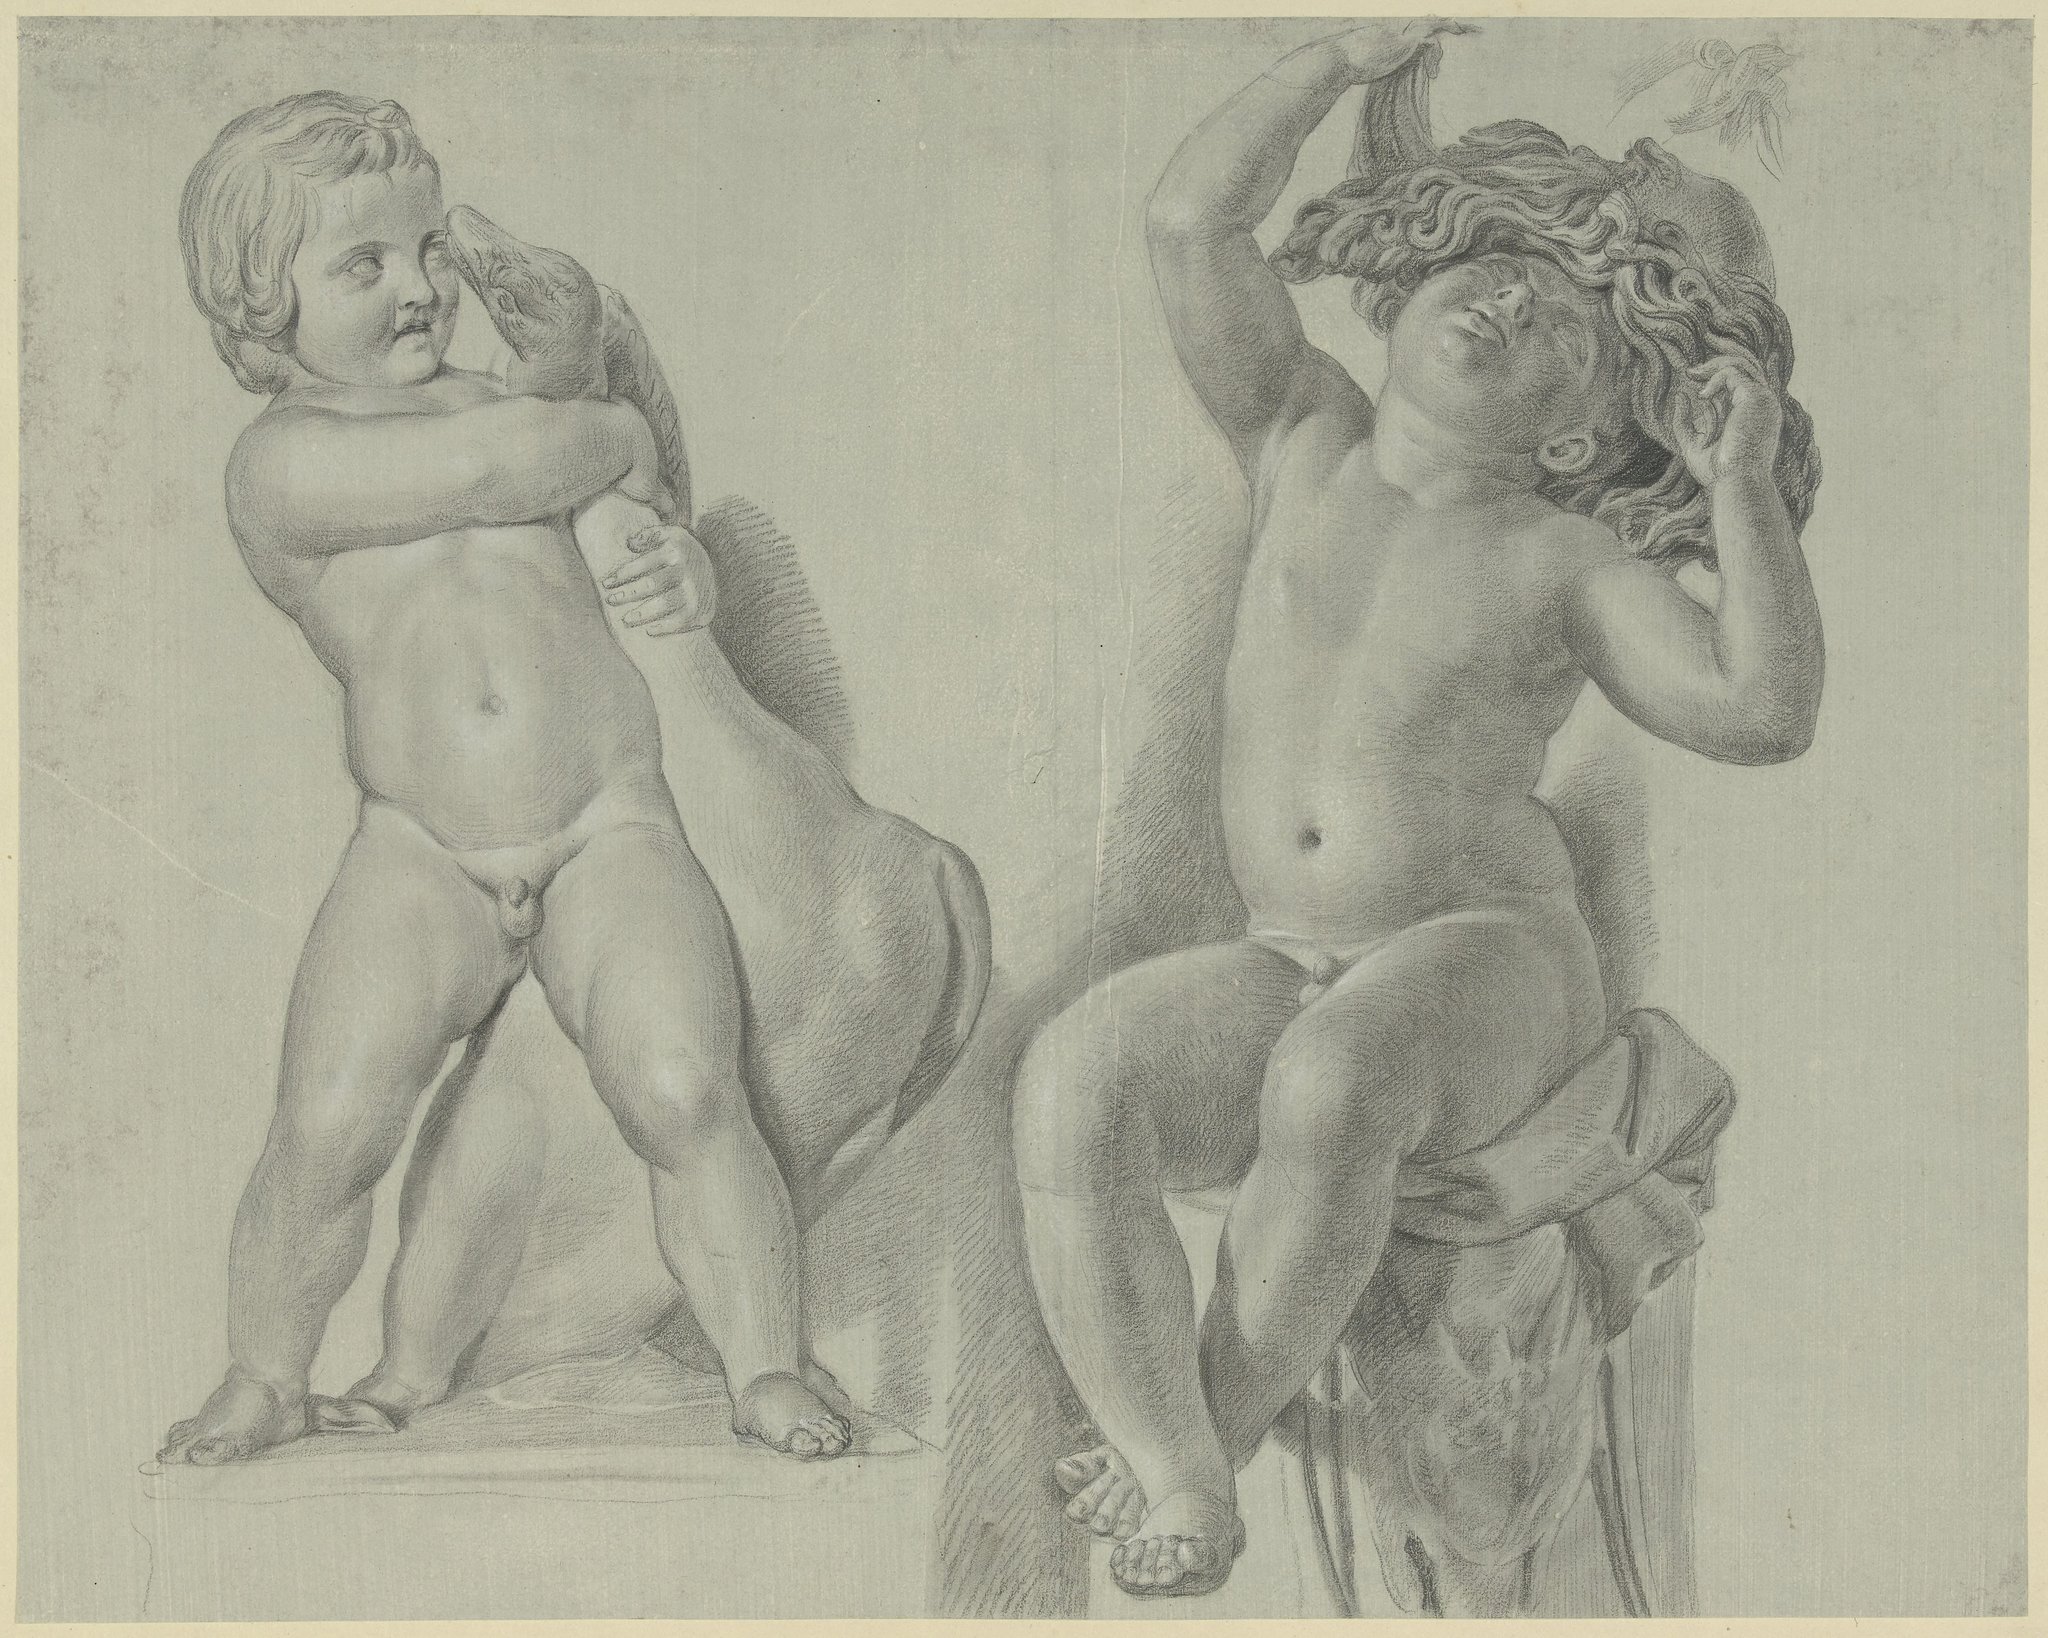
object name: drawing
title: Twee studies naar beeldhouwwerken van kinderen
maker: jean grandjean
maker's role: draughtsman, print maker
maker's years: 1752-1781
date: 1765-1781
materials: chalk, paper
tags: piece of sculpture, reproduction of a piece of sculpture